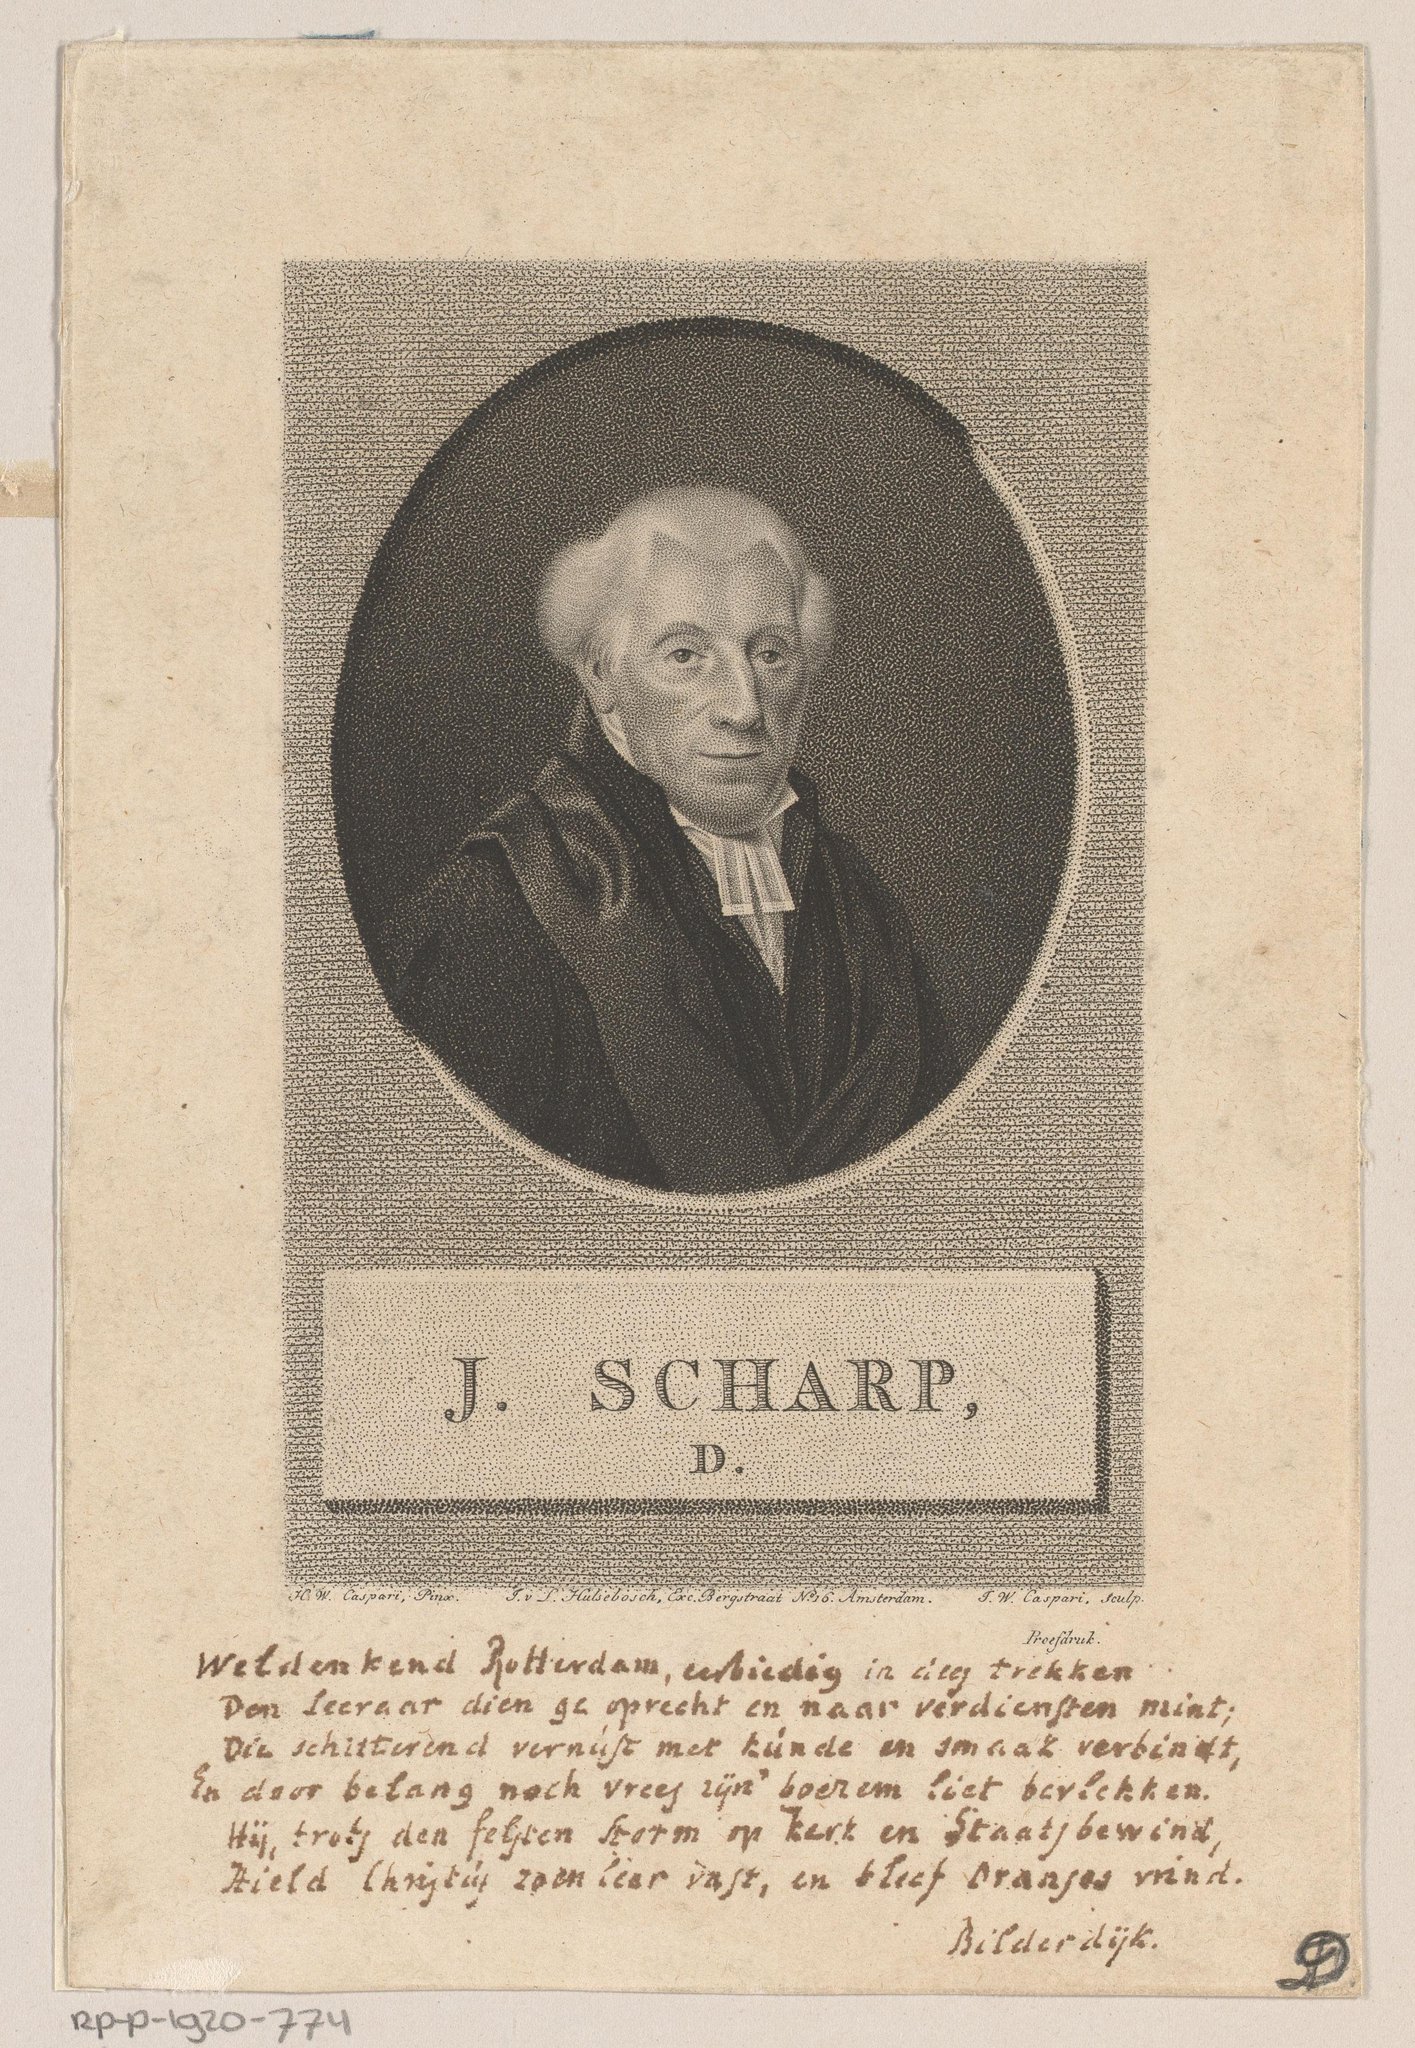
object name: print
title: Portret van Jan Scharp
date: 1812-1814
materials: paper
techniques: etching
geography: amsterdam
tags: the hague, rotterdam, jan scharp, theologian, historical persons, writer, poet, author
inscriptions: inscription: ‘Weldenkend Rotterdam, eerbiedig (...) Oranjes vrind. / Bilderdijk.’, collector's mark: Lugt 2228